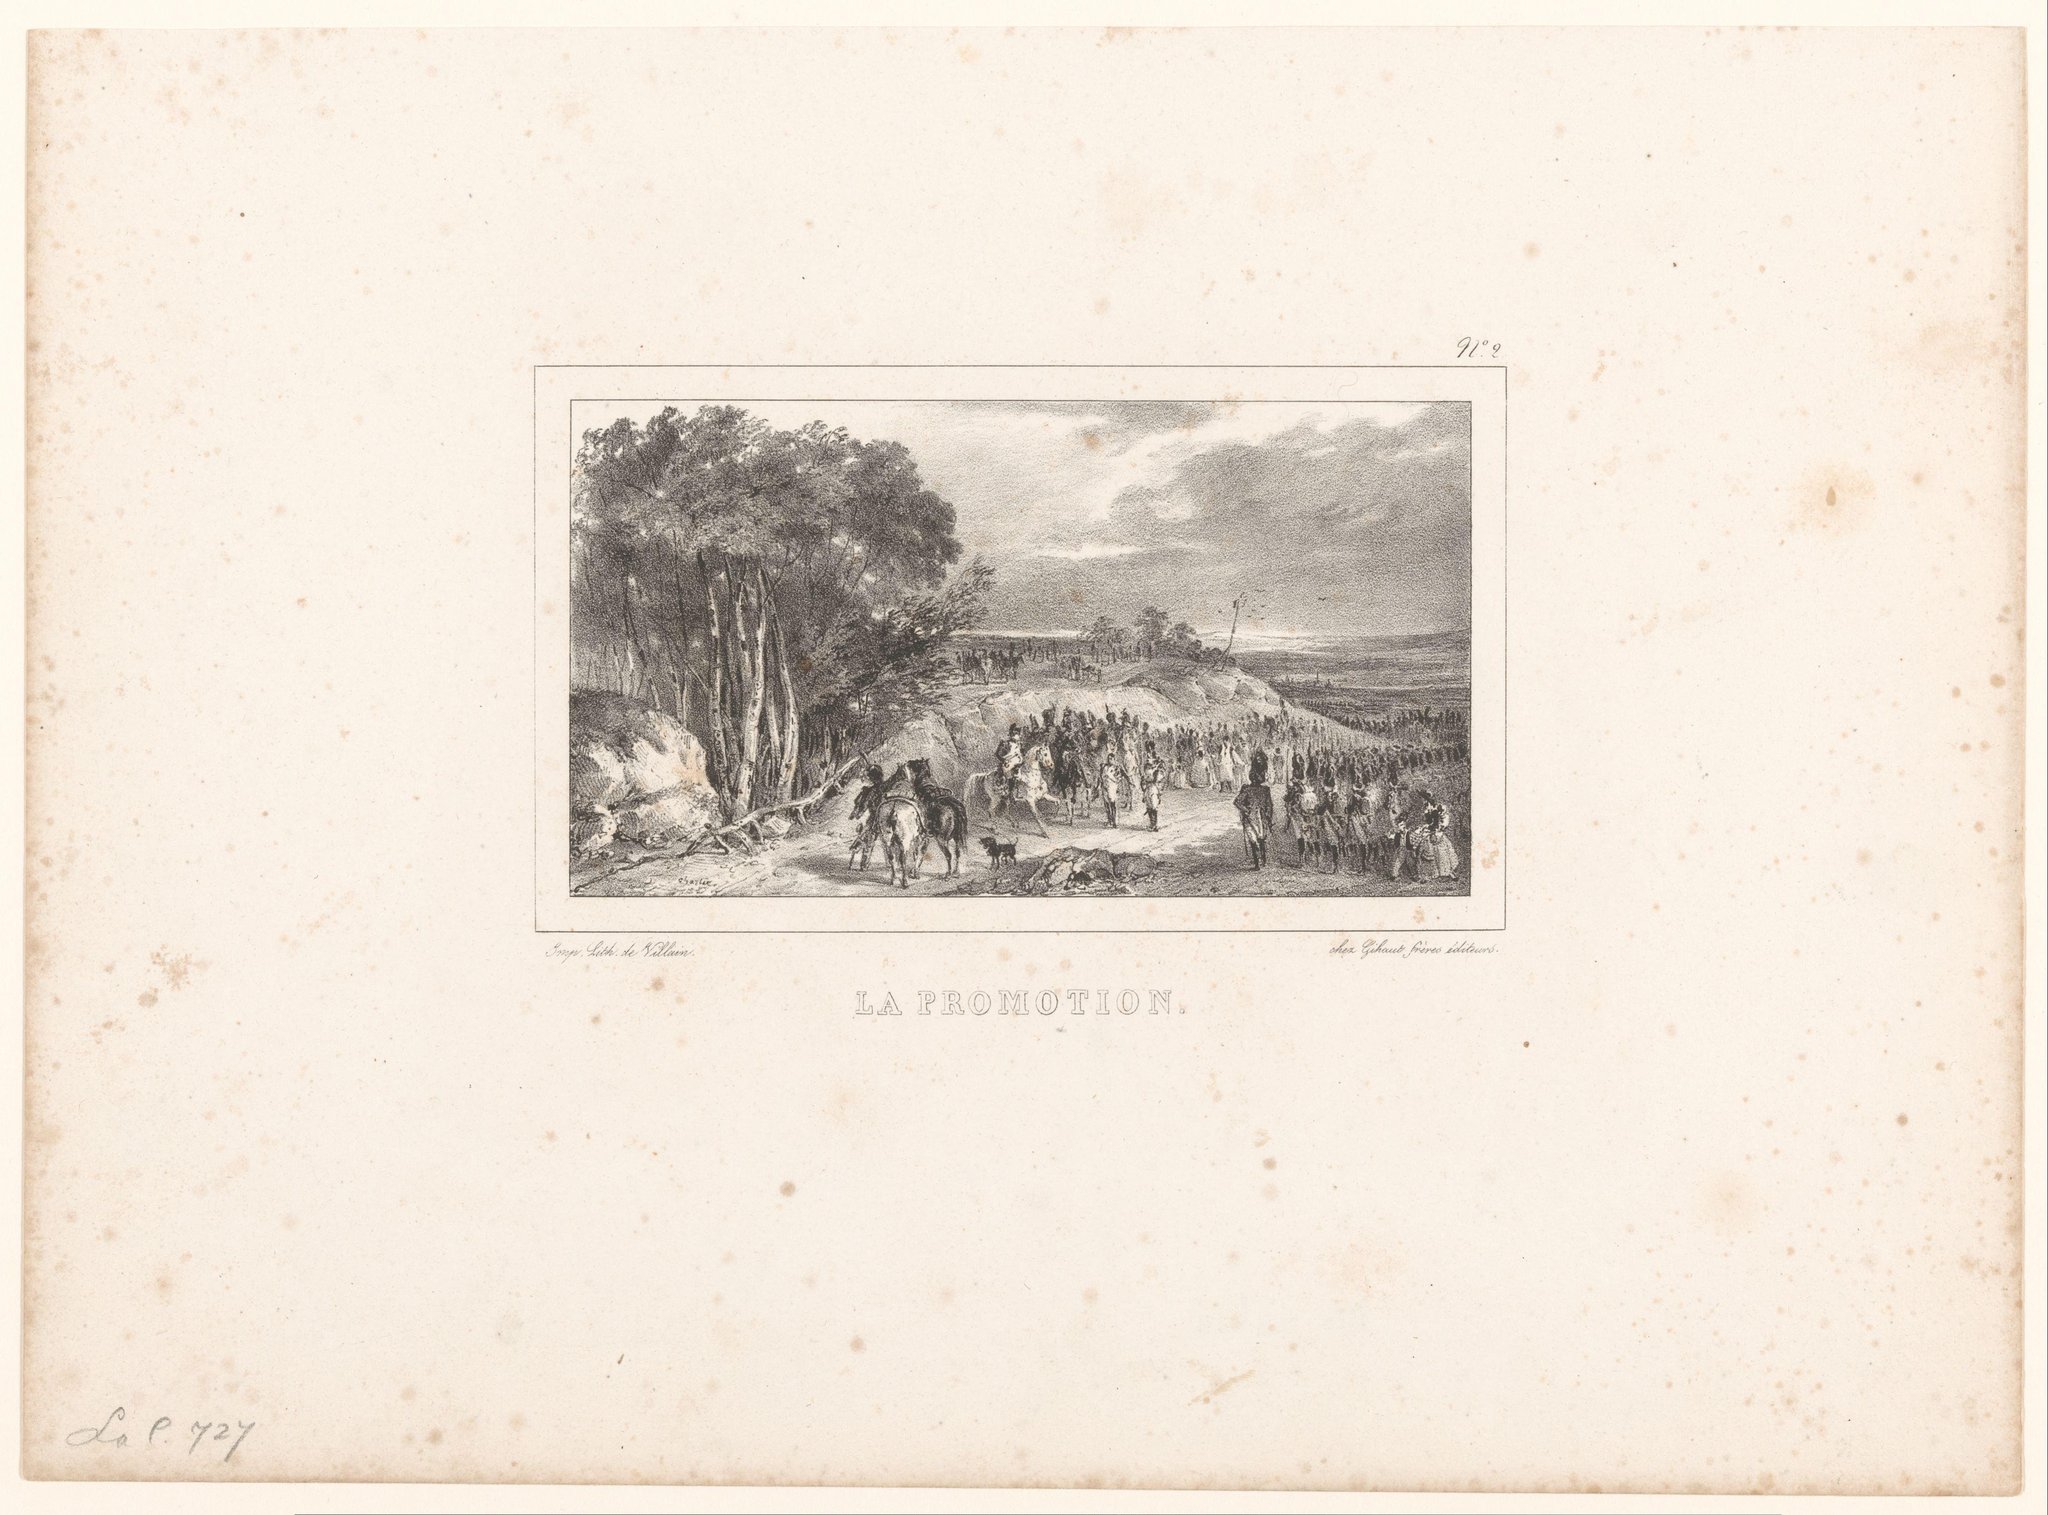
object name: print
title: Lithografisch album 1829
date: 1829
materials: paper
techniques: lithograph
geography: paris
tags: low hill country, promotion (military honour)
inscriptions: collector's mark: Lugt 2228a